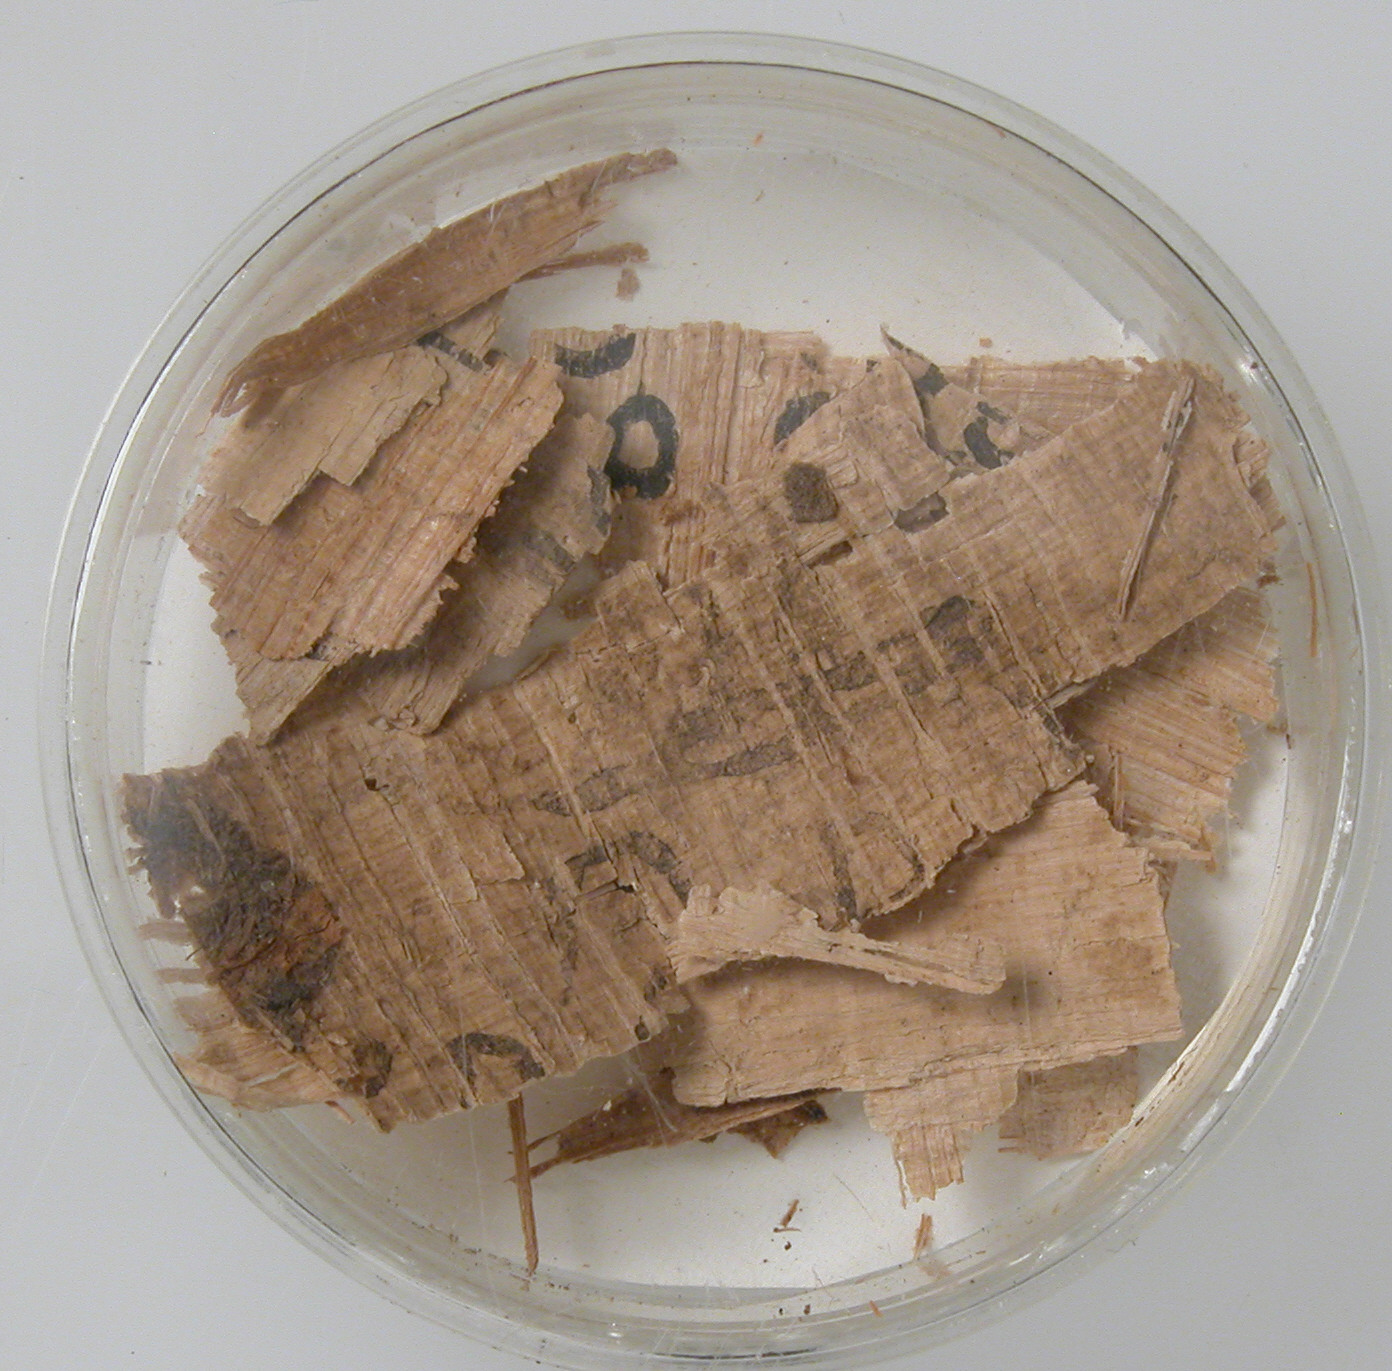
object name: fragment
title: Papyri Fragments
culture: coptic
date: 601-700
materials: ink, papyrus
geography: egypt